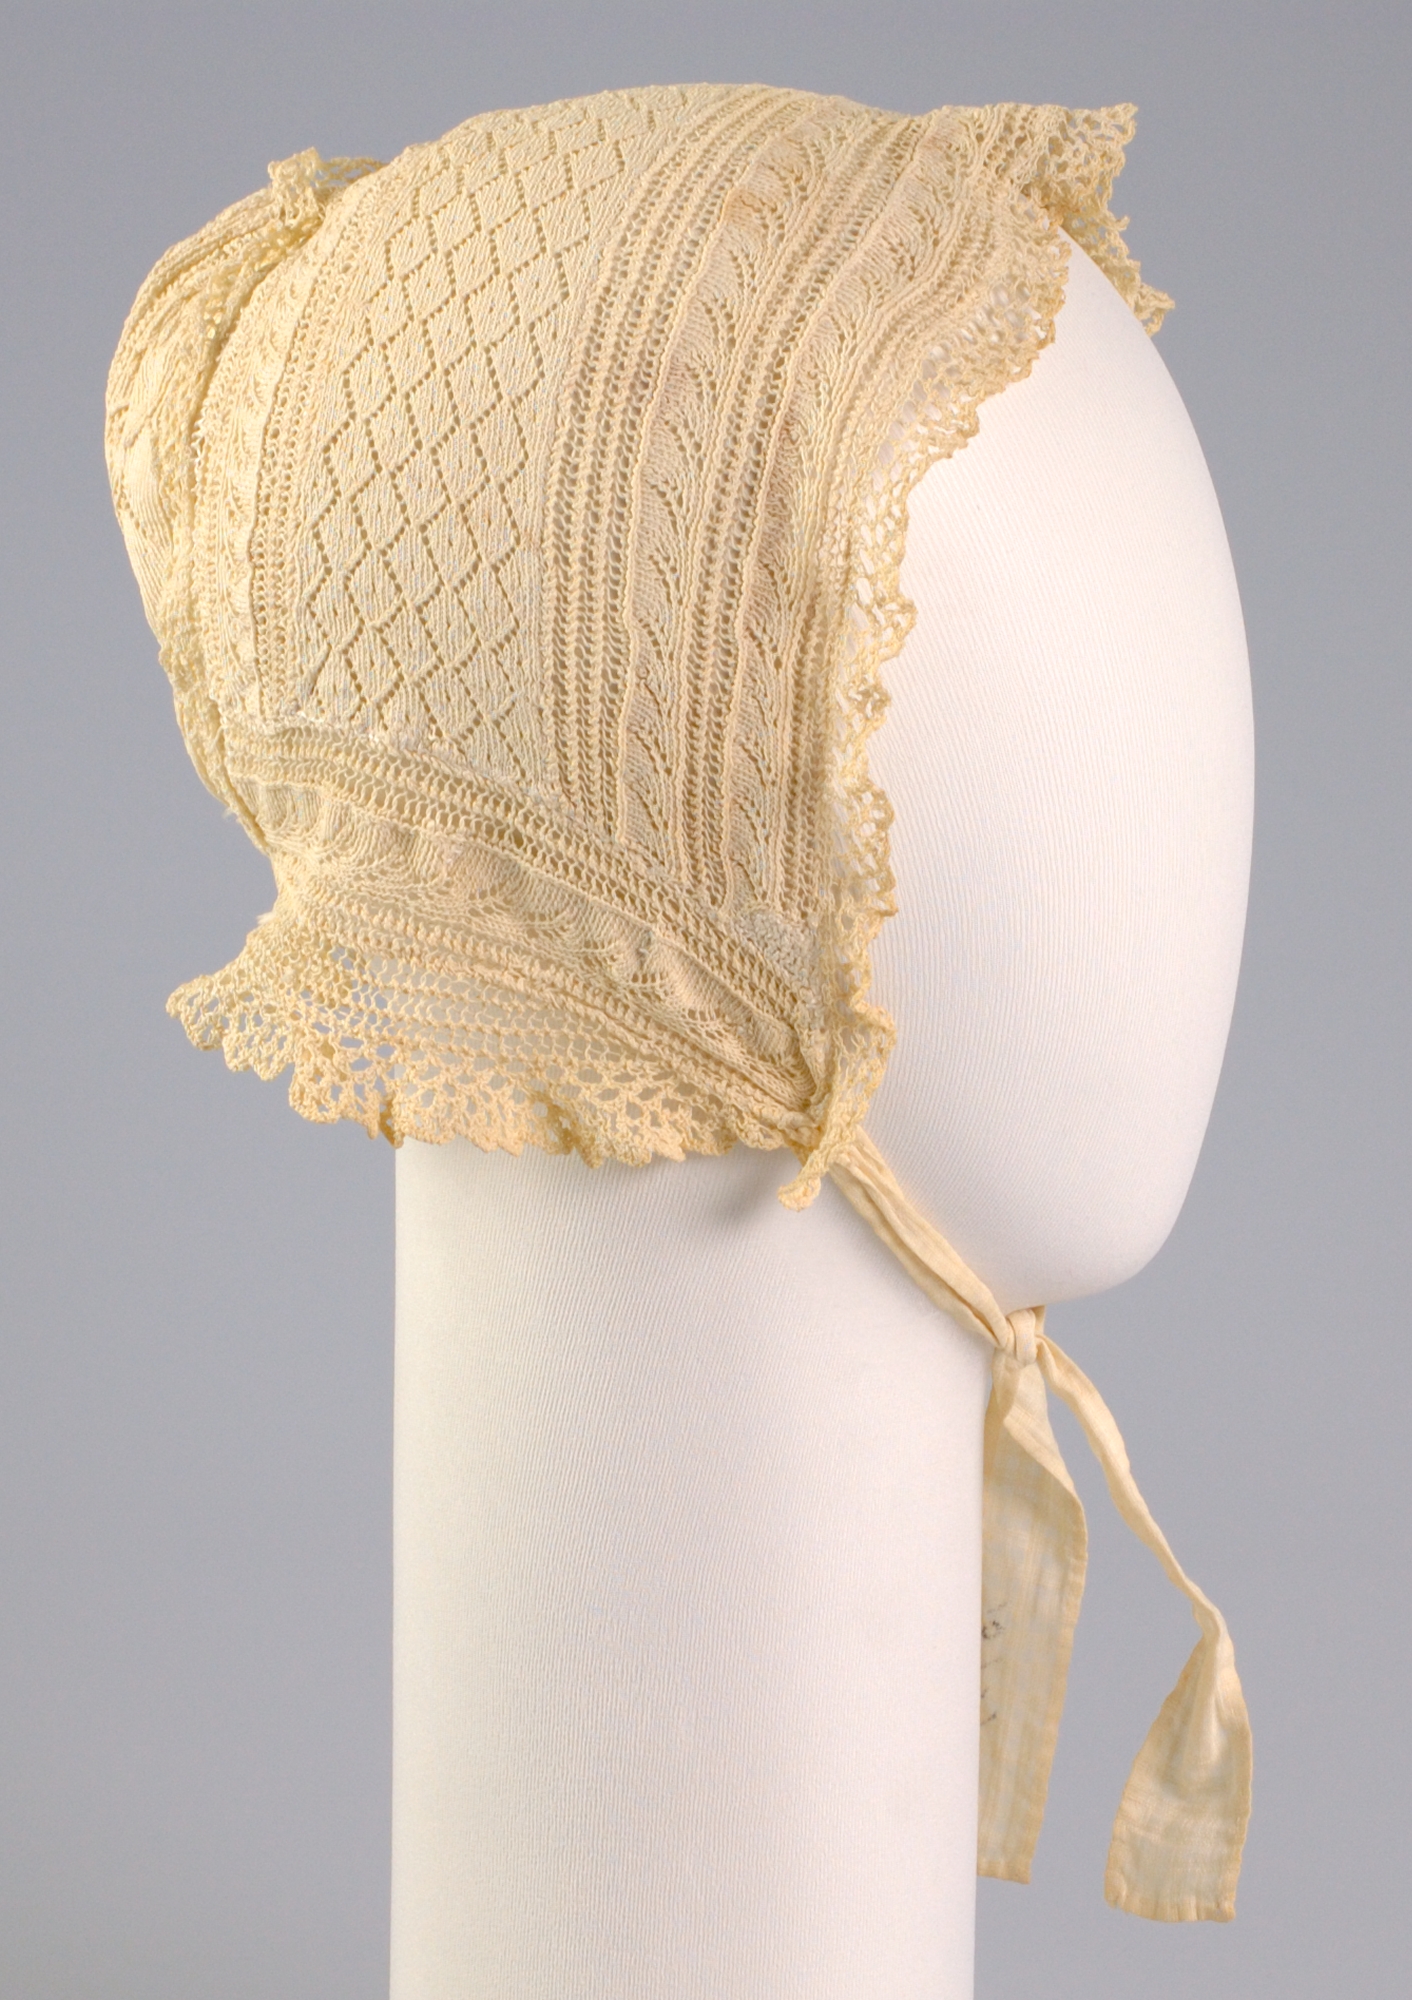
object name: cap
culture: american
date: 1860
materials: cotton